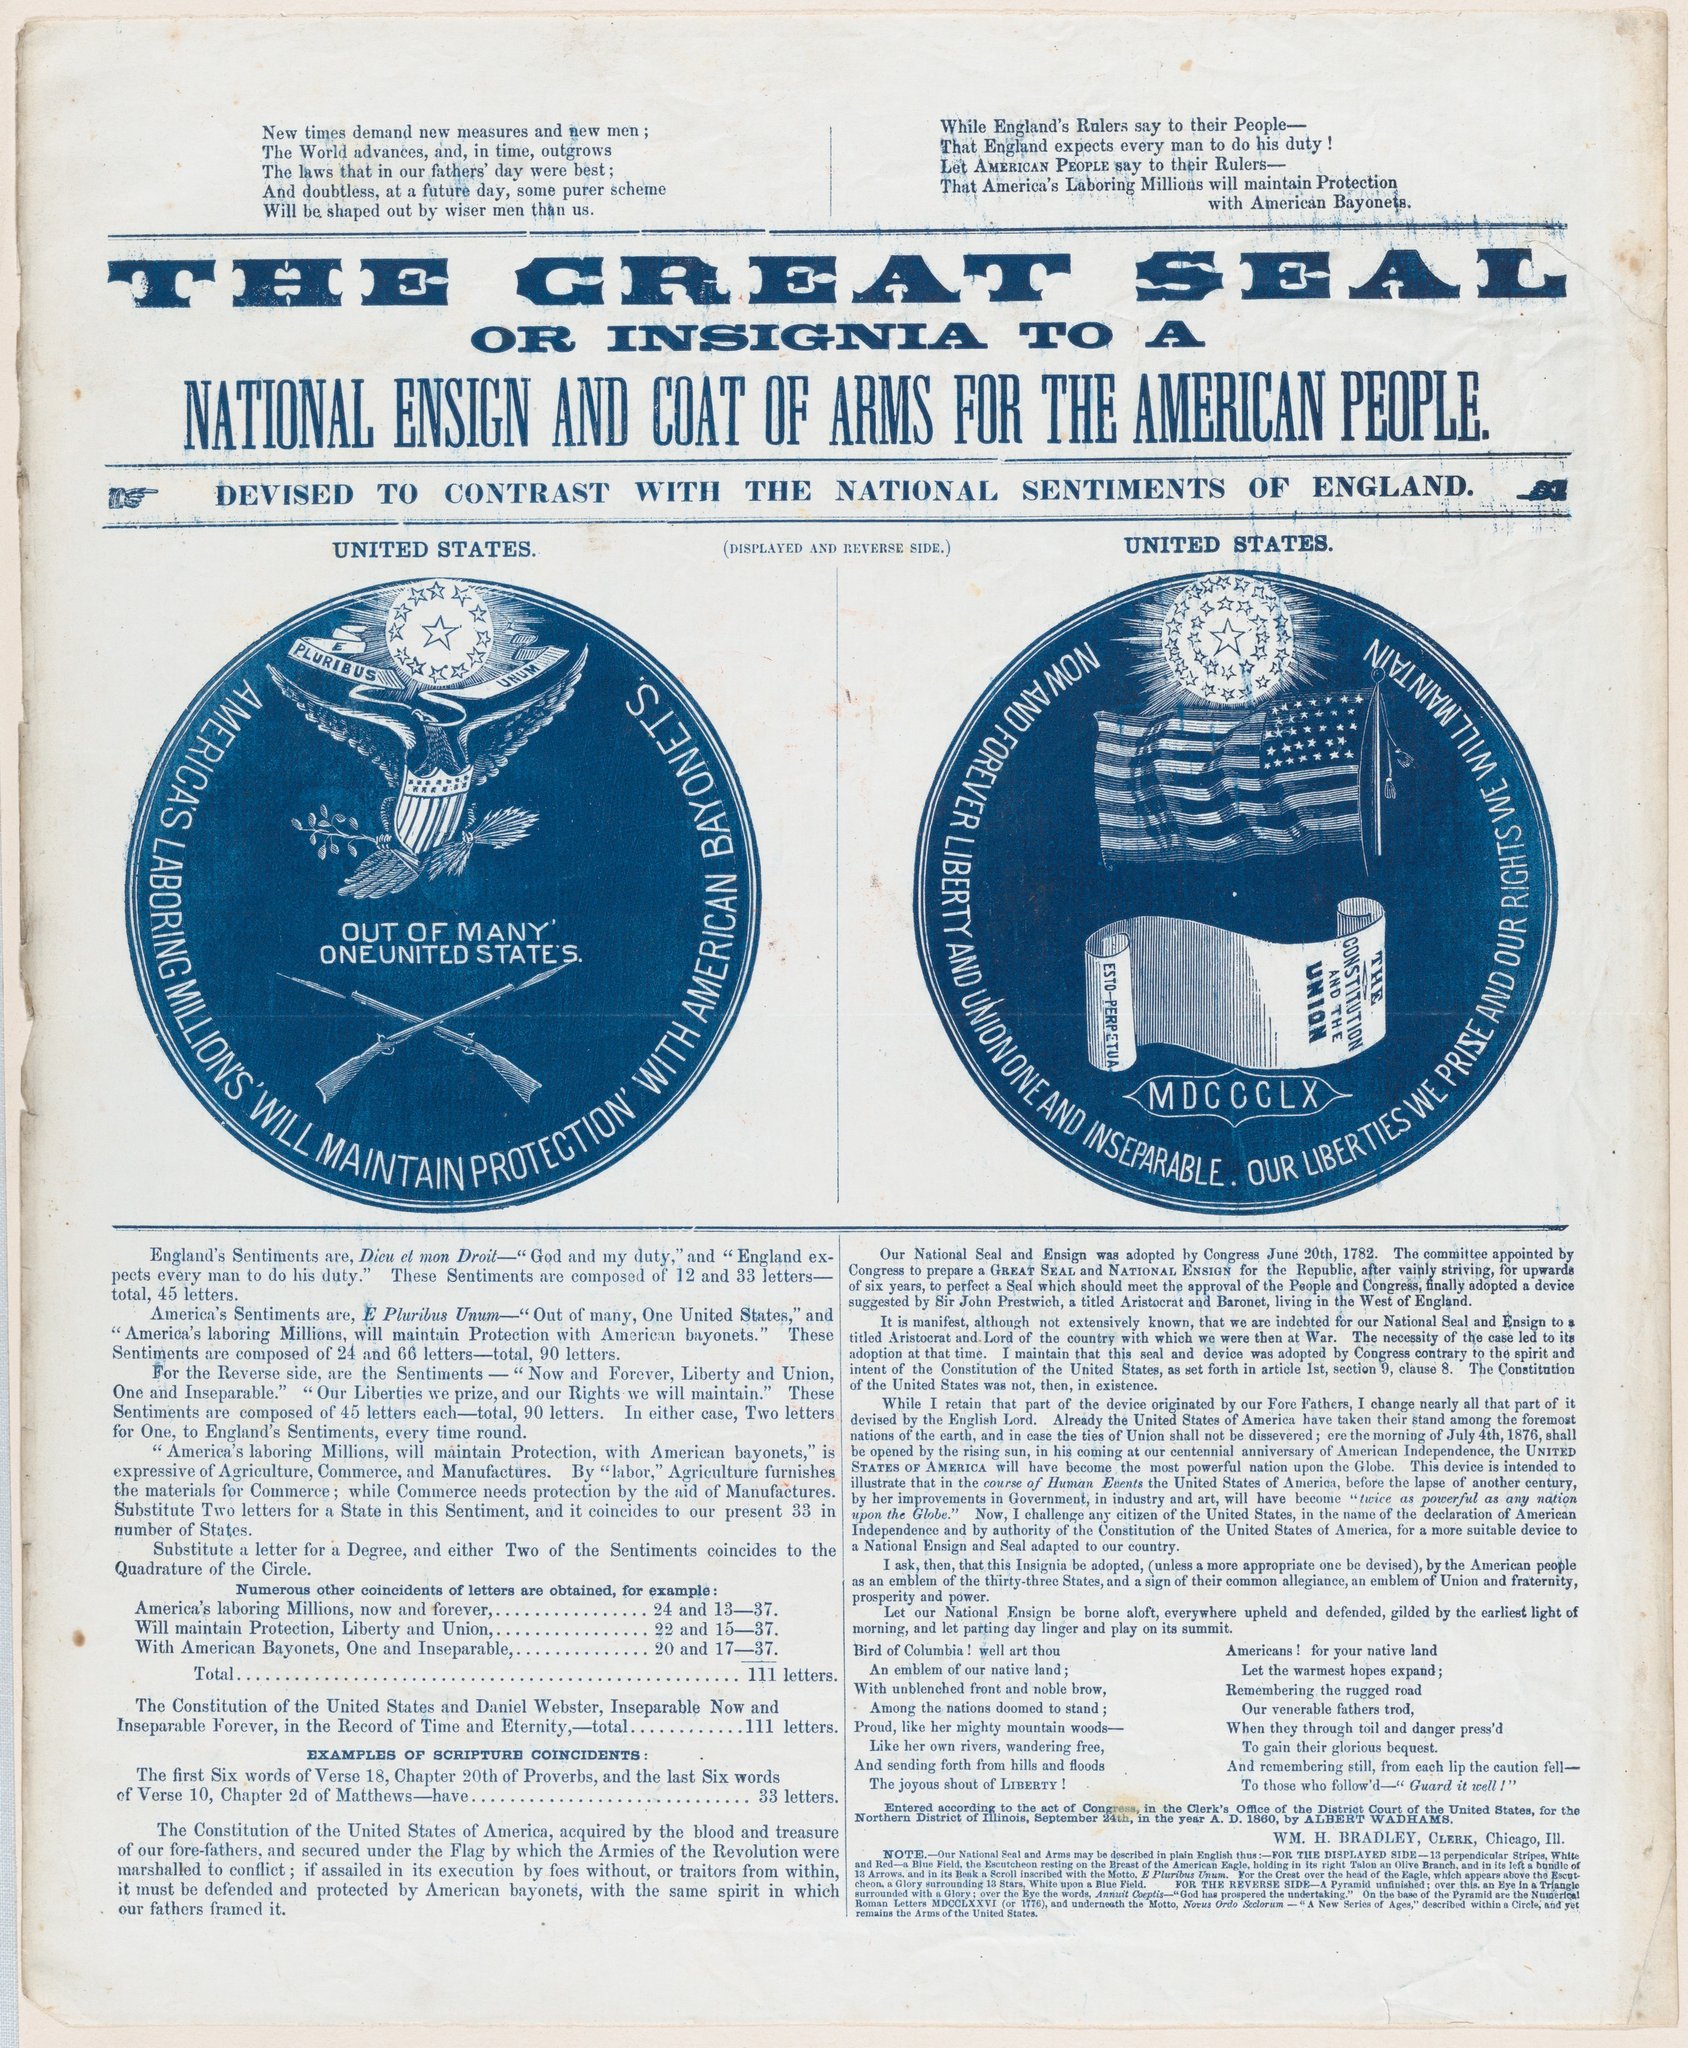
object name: book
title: Complete And Permanent System of Cutting All Kinds of Garments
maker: w. h. stinemets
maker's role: author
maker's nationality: american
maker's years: 1800-1900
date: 1843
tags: birds,firearms,flags,insignia